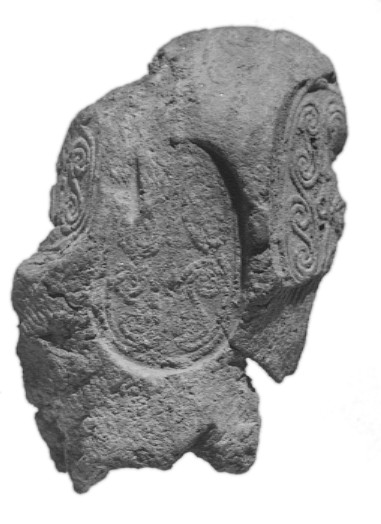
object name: sealing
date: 2030-1640 BCE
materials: clay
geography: egypt